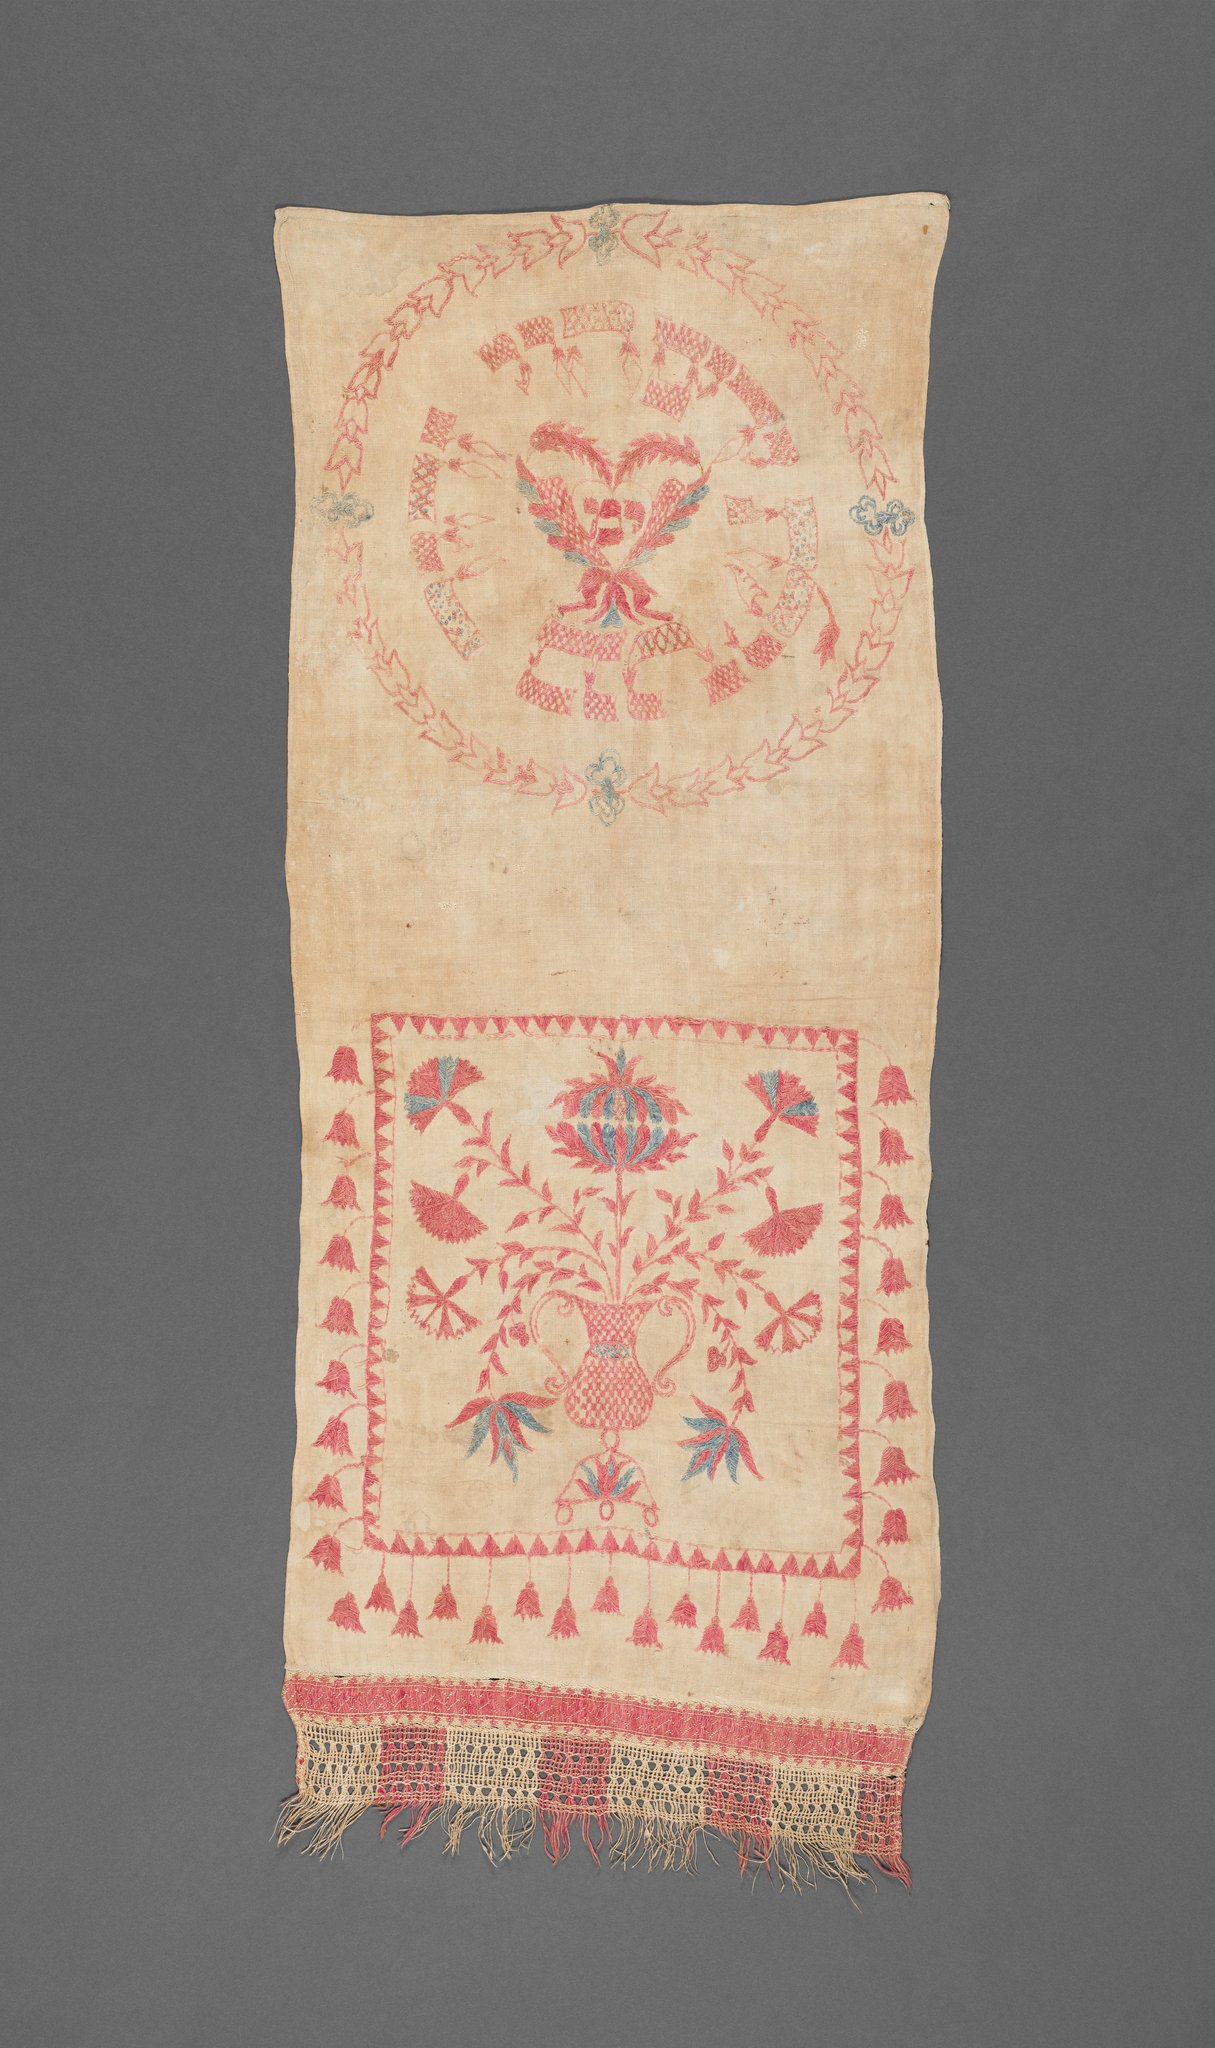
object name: towel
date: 1701-1800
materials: linen